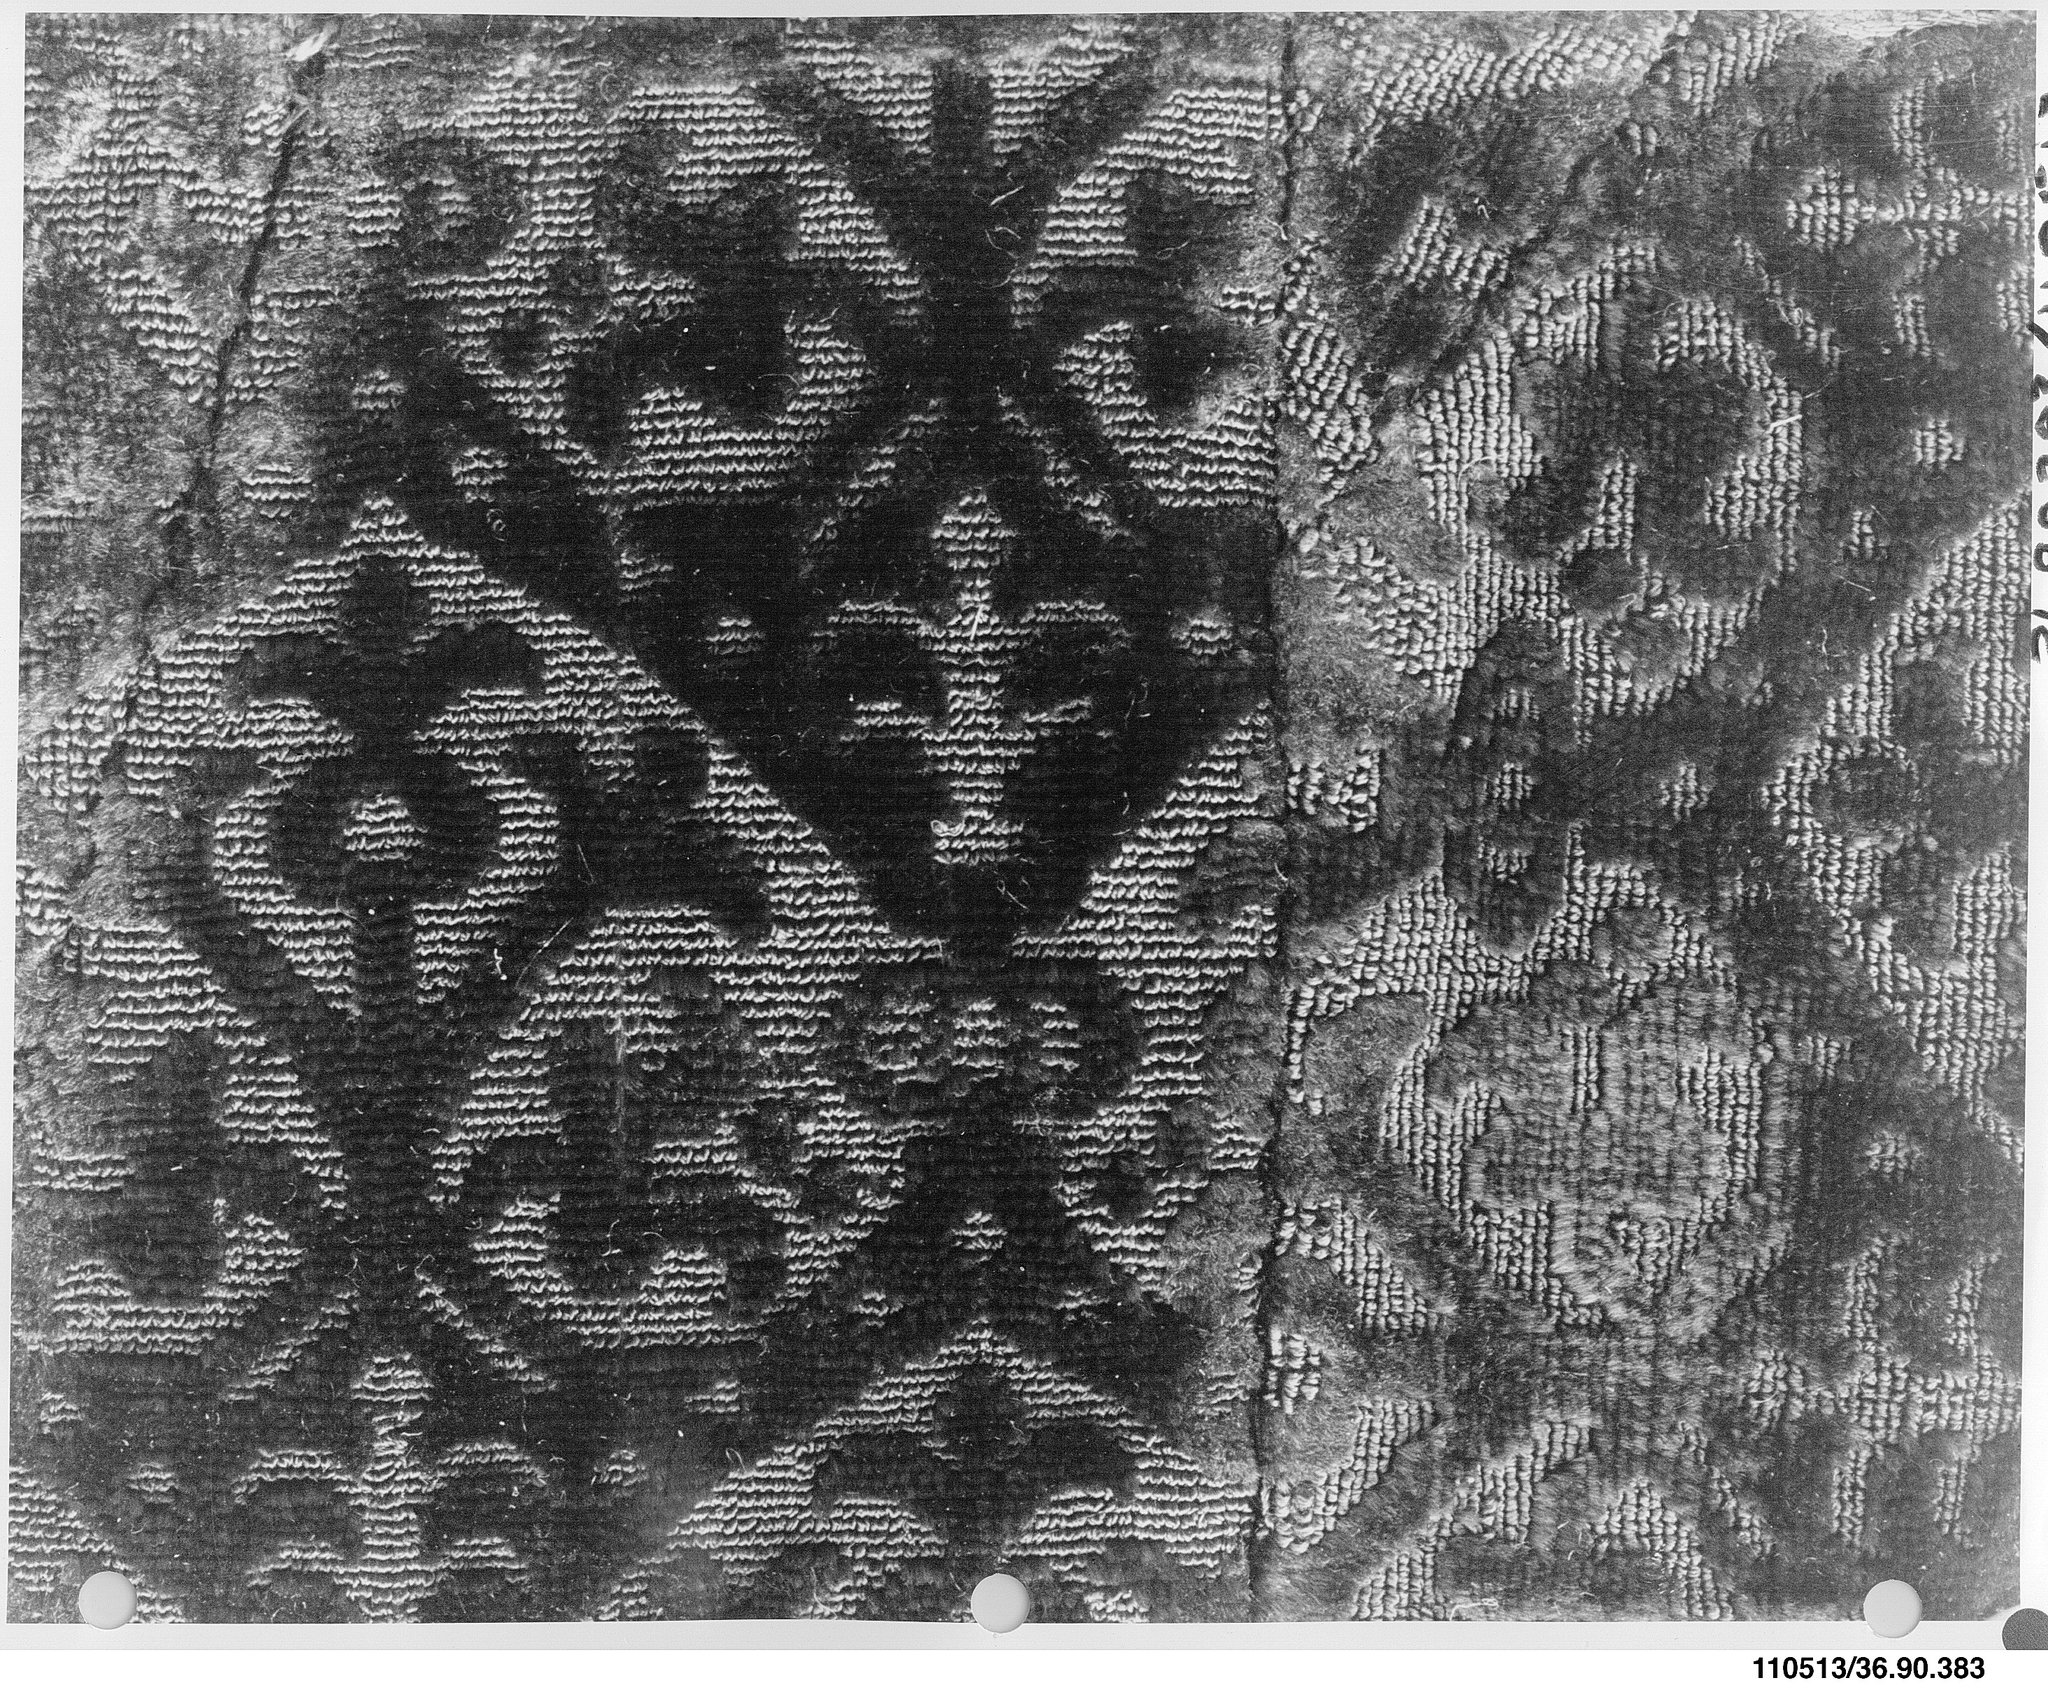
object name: piece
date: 1501-1700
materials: silk